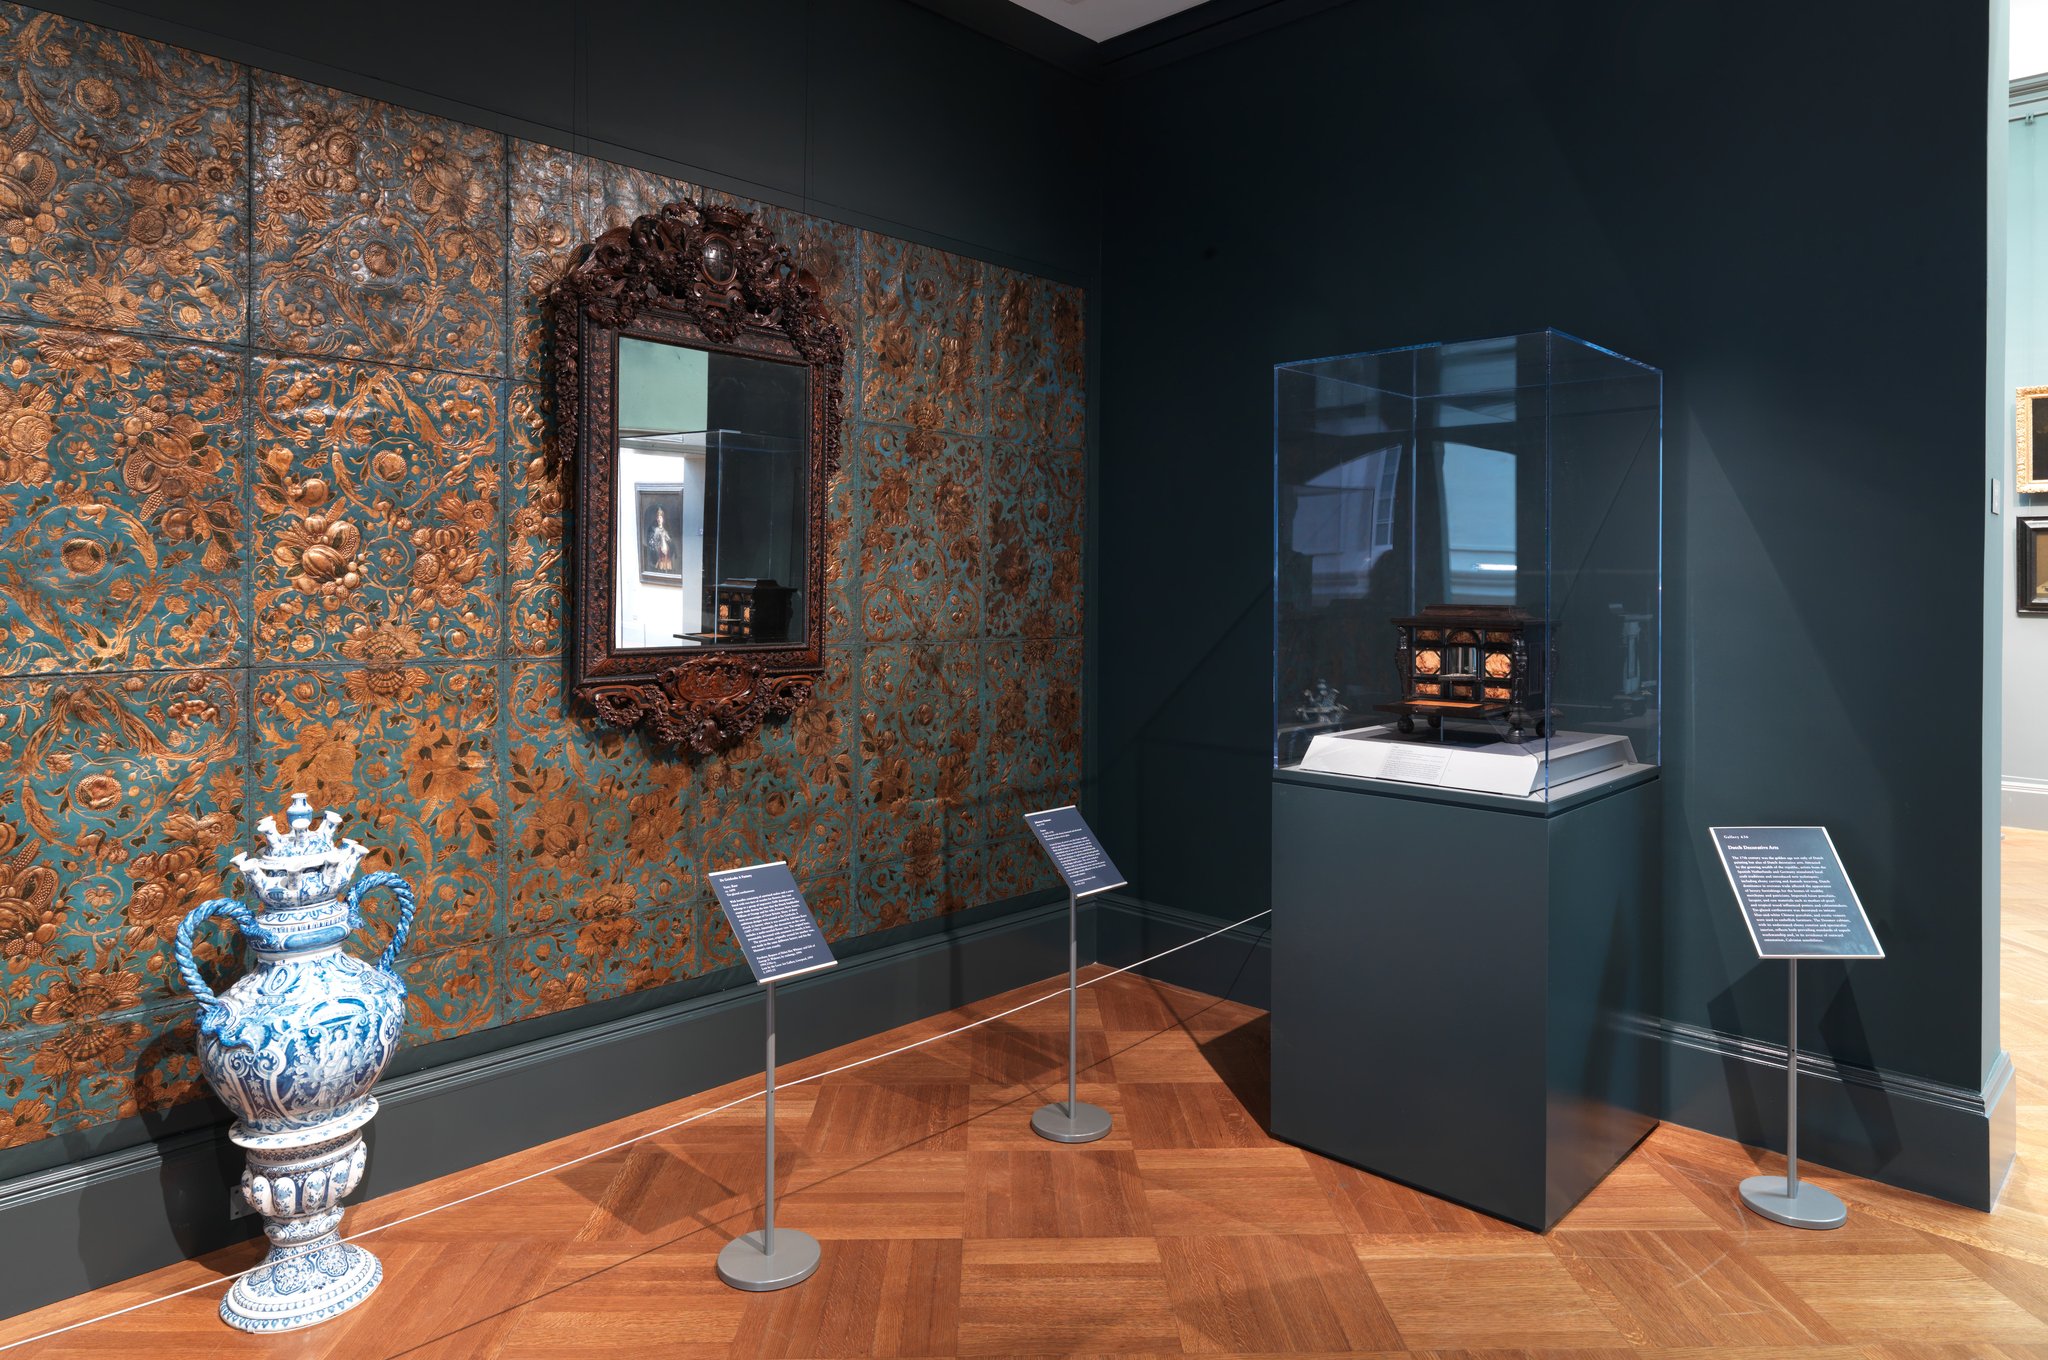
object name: hanging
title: Gilt-leather wall hangings (part of a set)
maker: de gecroonde son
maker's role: maker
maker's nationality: dutch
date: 1650-1670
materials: leather, varnish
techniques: painting, silvered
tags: fruit,putti,monkeys,flowers